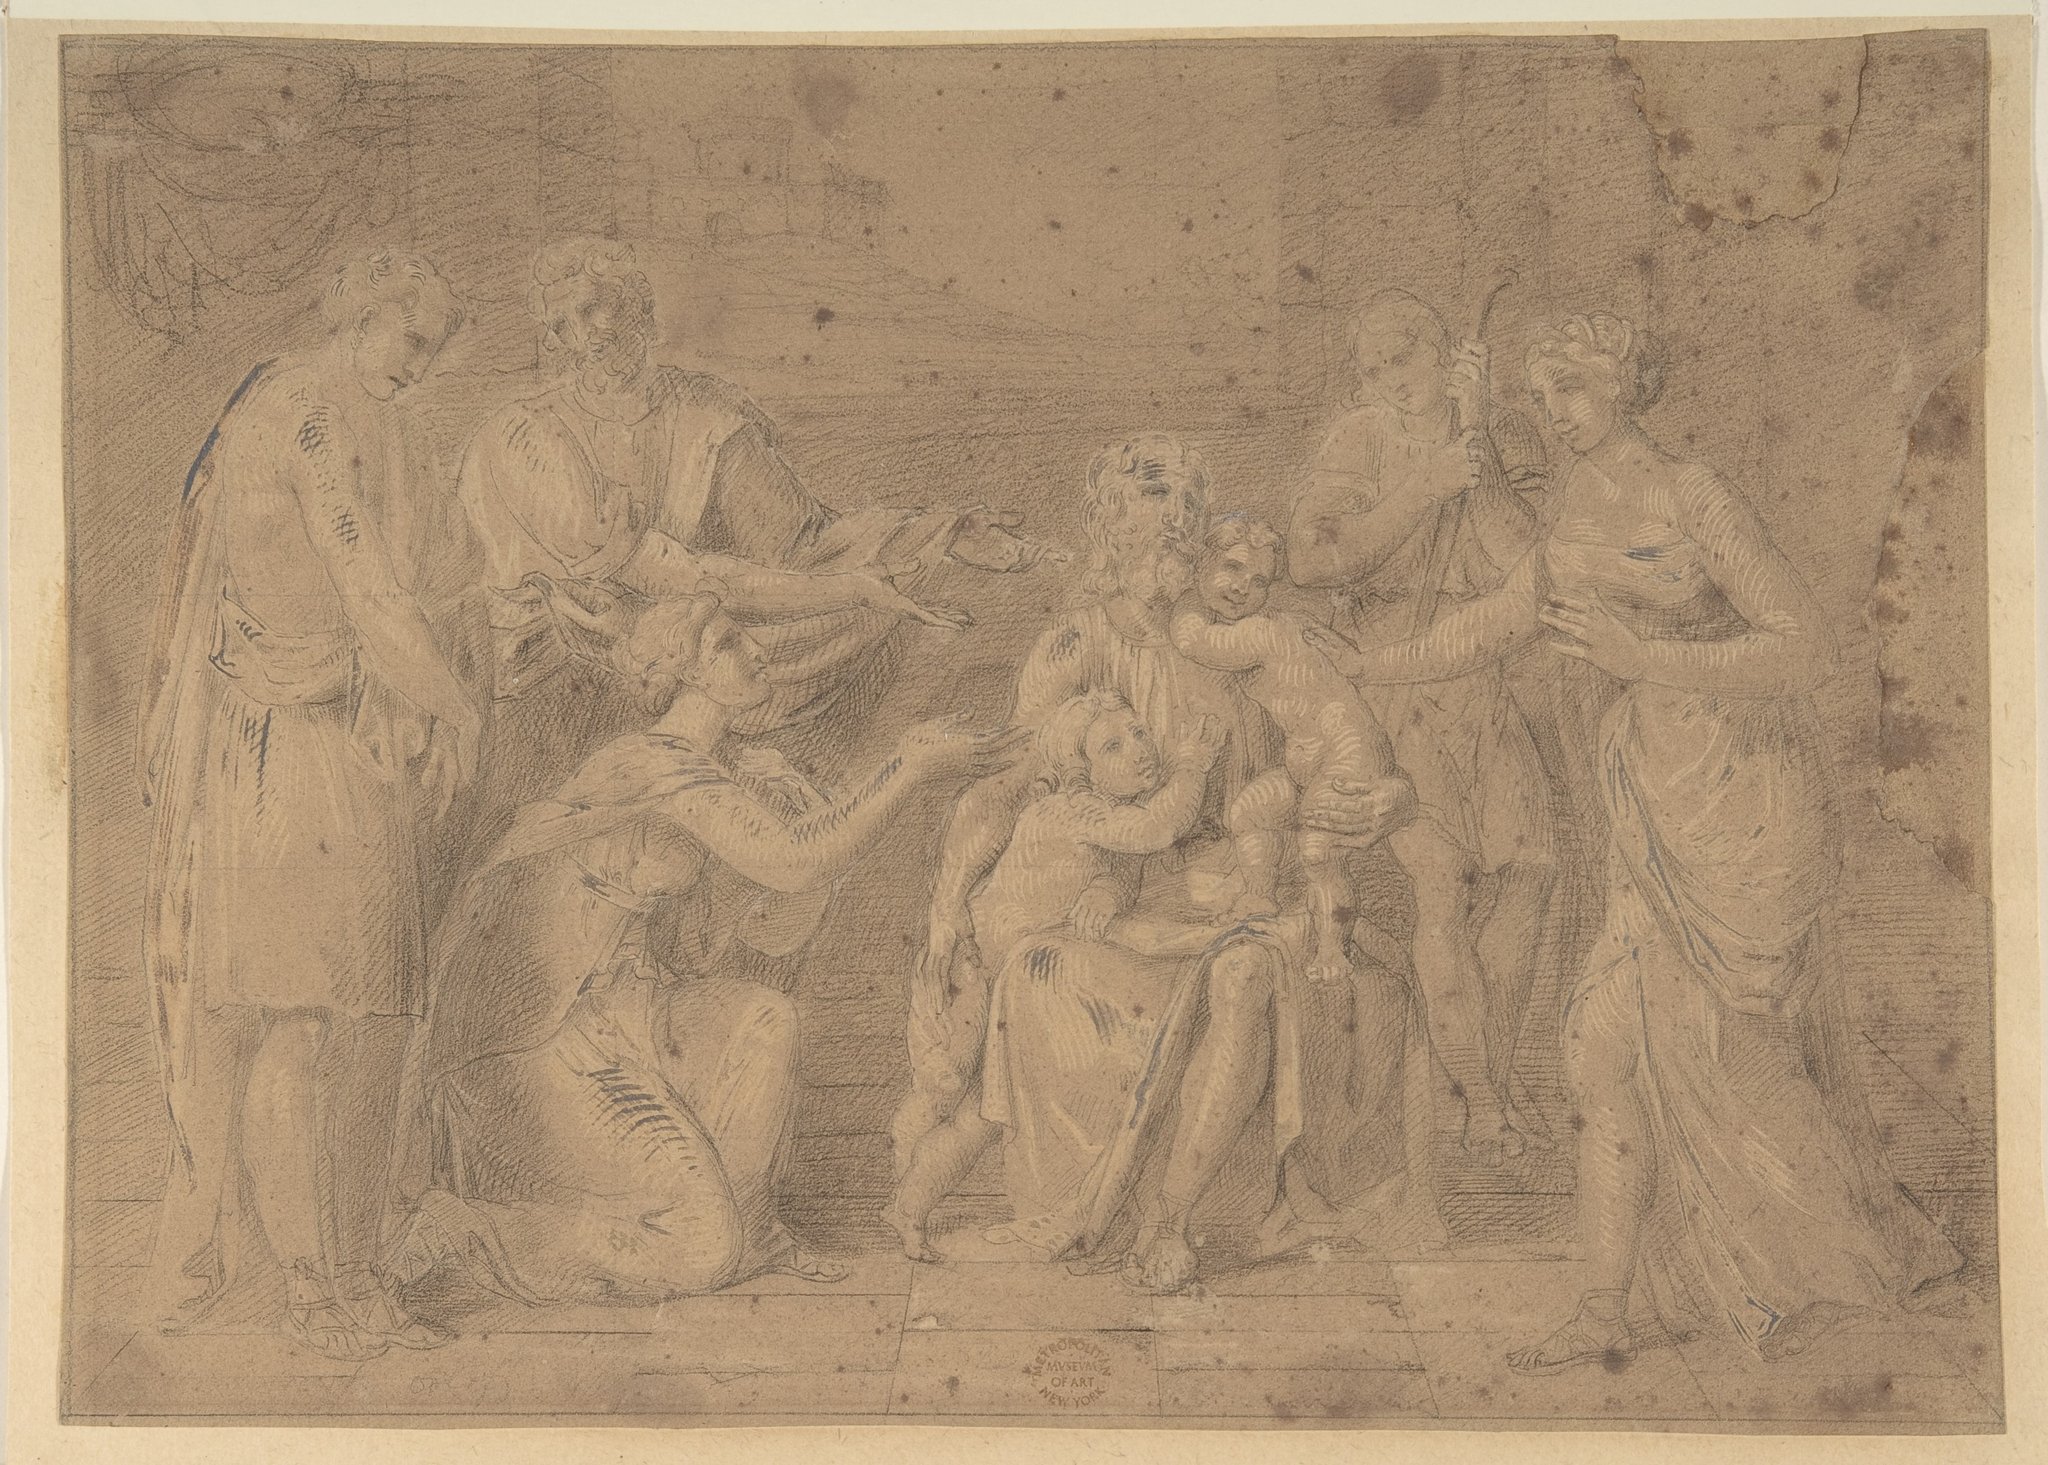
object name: drawing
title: Christ and the Children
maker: anonymous, italian, roman-bolognese, 17th century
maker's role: artist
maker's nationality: italian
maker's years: 1600-1700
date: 1601-1700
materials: chalk, gouache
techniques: highlighting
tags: children,men,women,christ